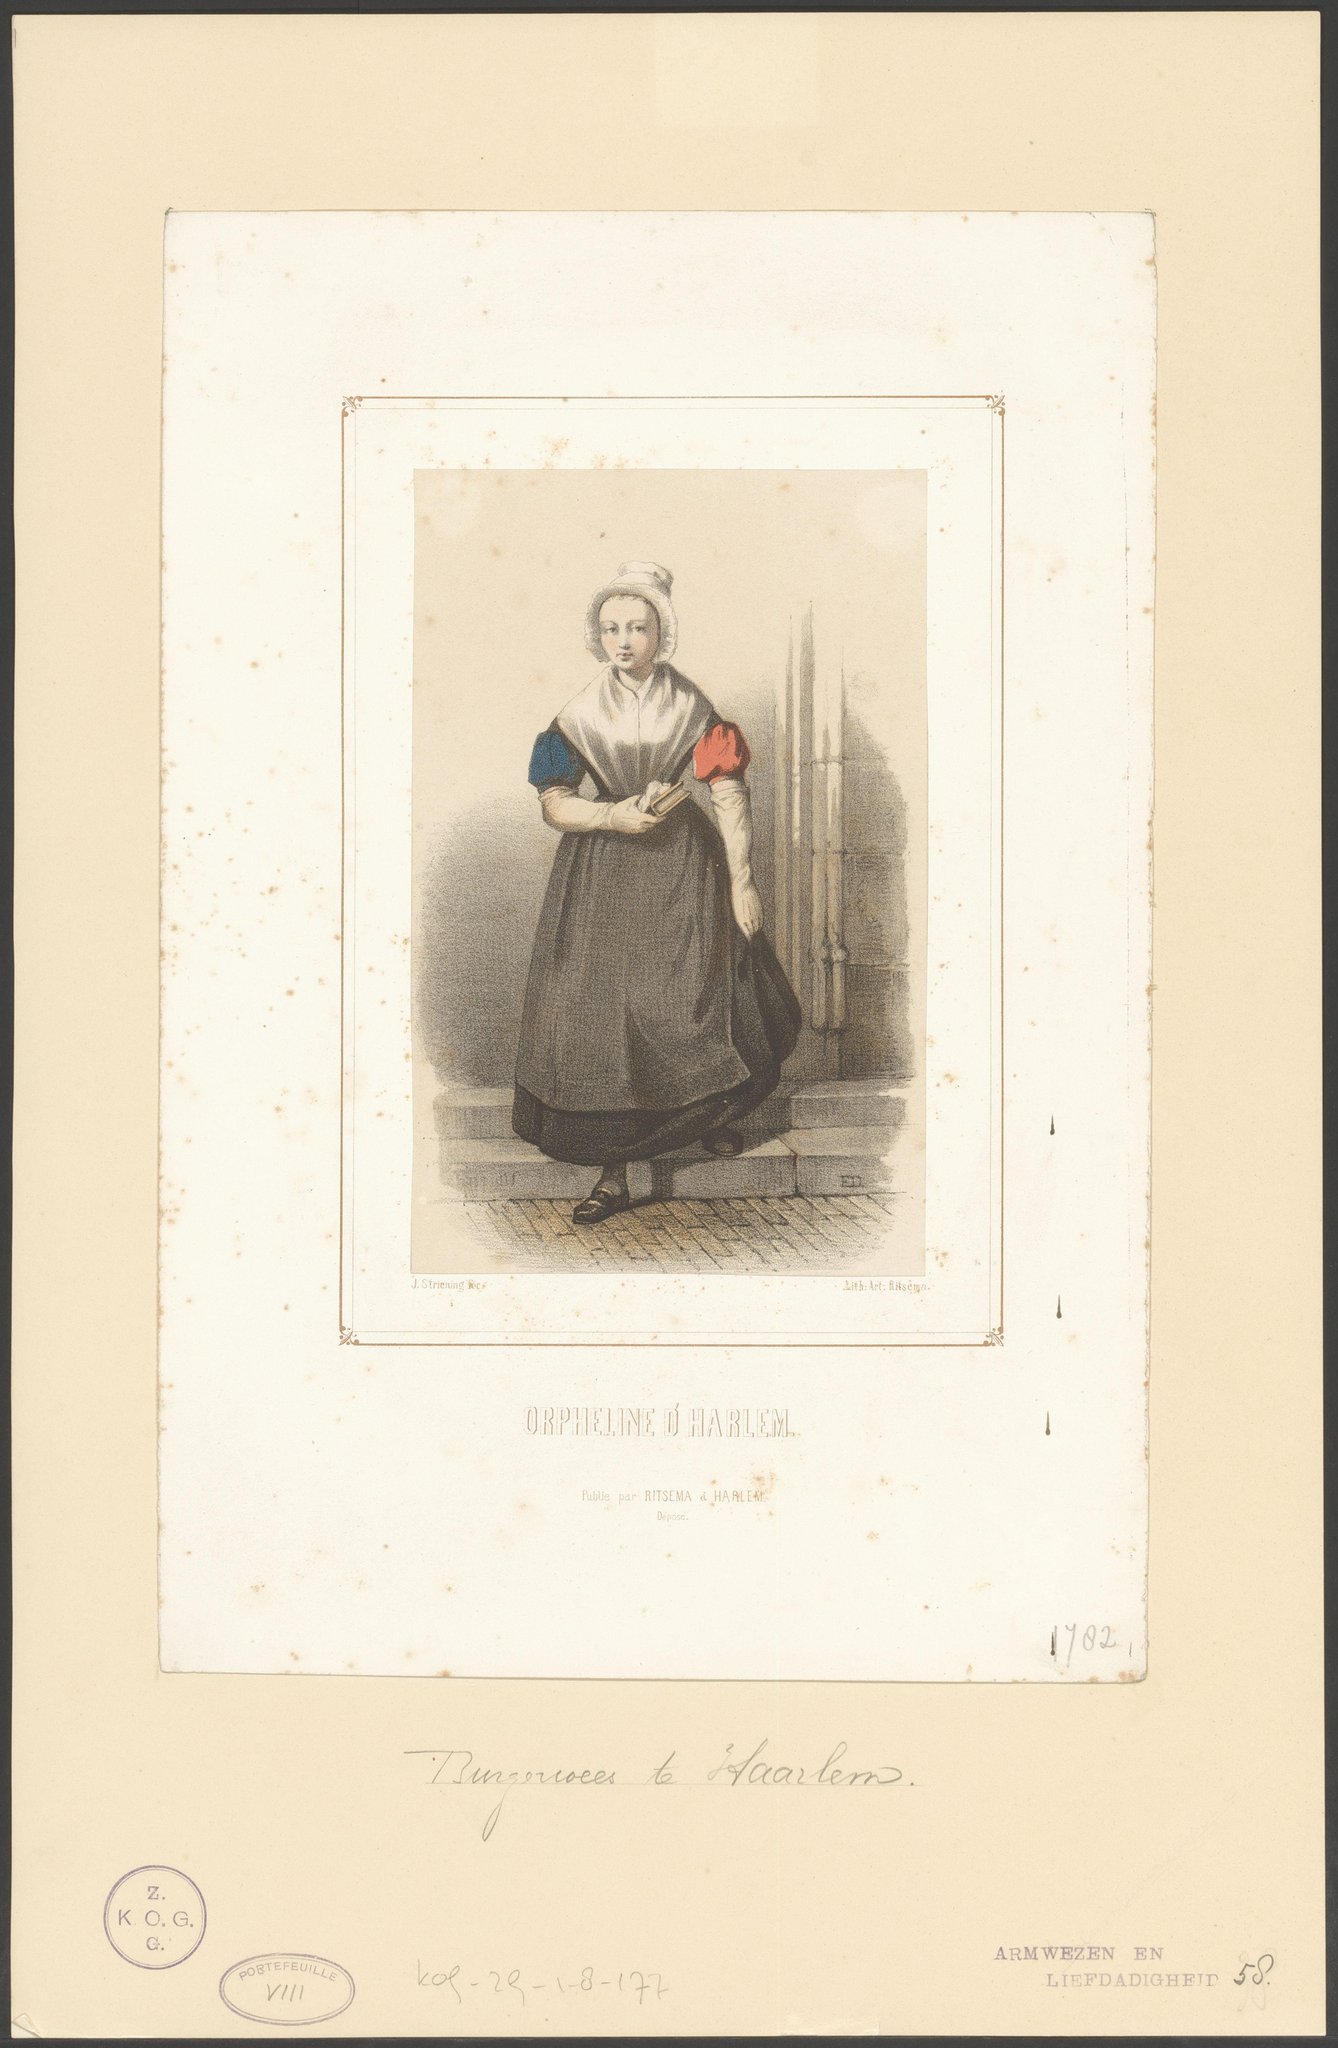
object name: print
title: Haarlems weesmeisje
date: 1850-1875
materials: paper, watercolor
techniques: hand coloring, lithograph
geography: haarlem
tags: public welfare, leaving the church after service, folk costume, regional costume, orphans, amsterdam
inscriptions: collector's mark: Lugt 1641, collector's mark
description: Haarlems weesmeisje die de kerk uitkomt. Het meisje heeft een bijbel in haar rechterhand. Uit een serie van afbeeldingen van weeskinderen. Onderwerpsrubrieken binnen de Atlas Zeden en Gewoonten: Armwezen en Liefdadigheid.